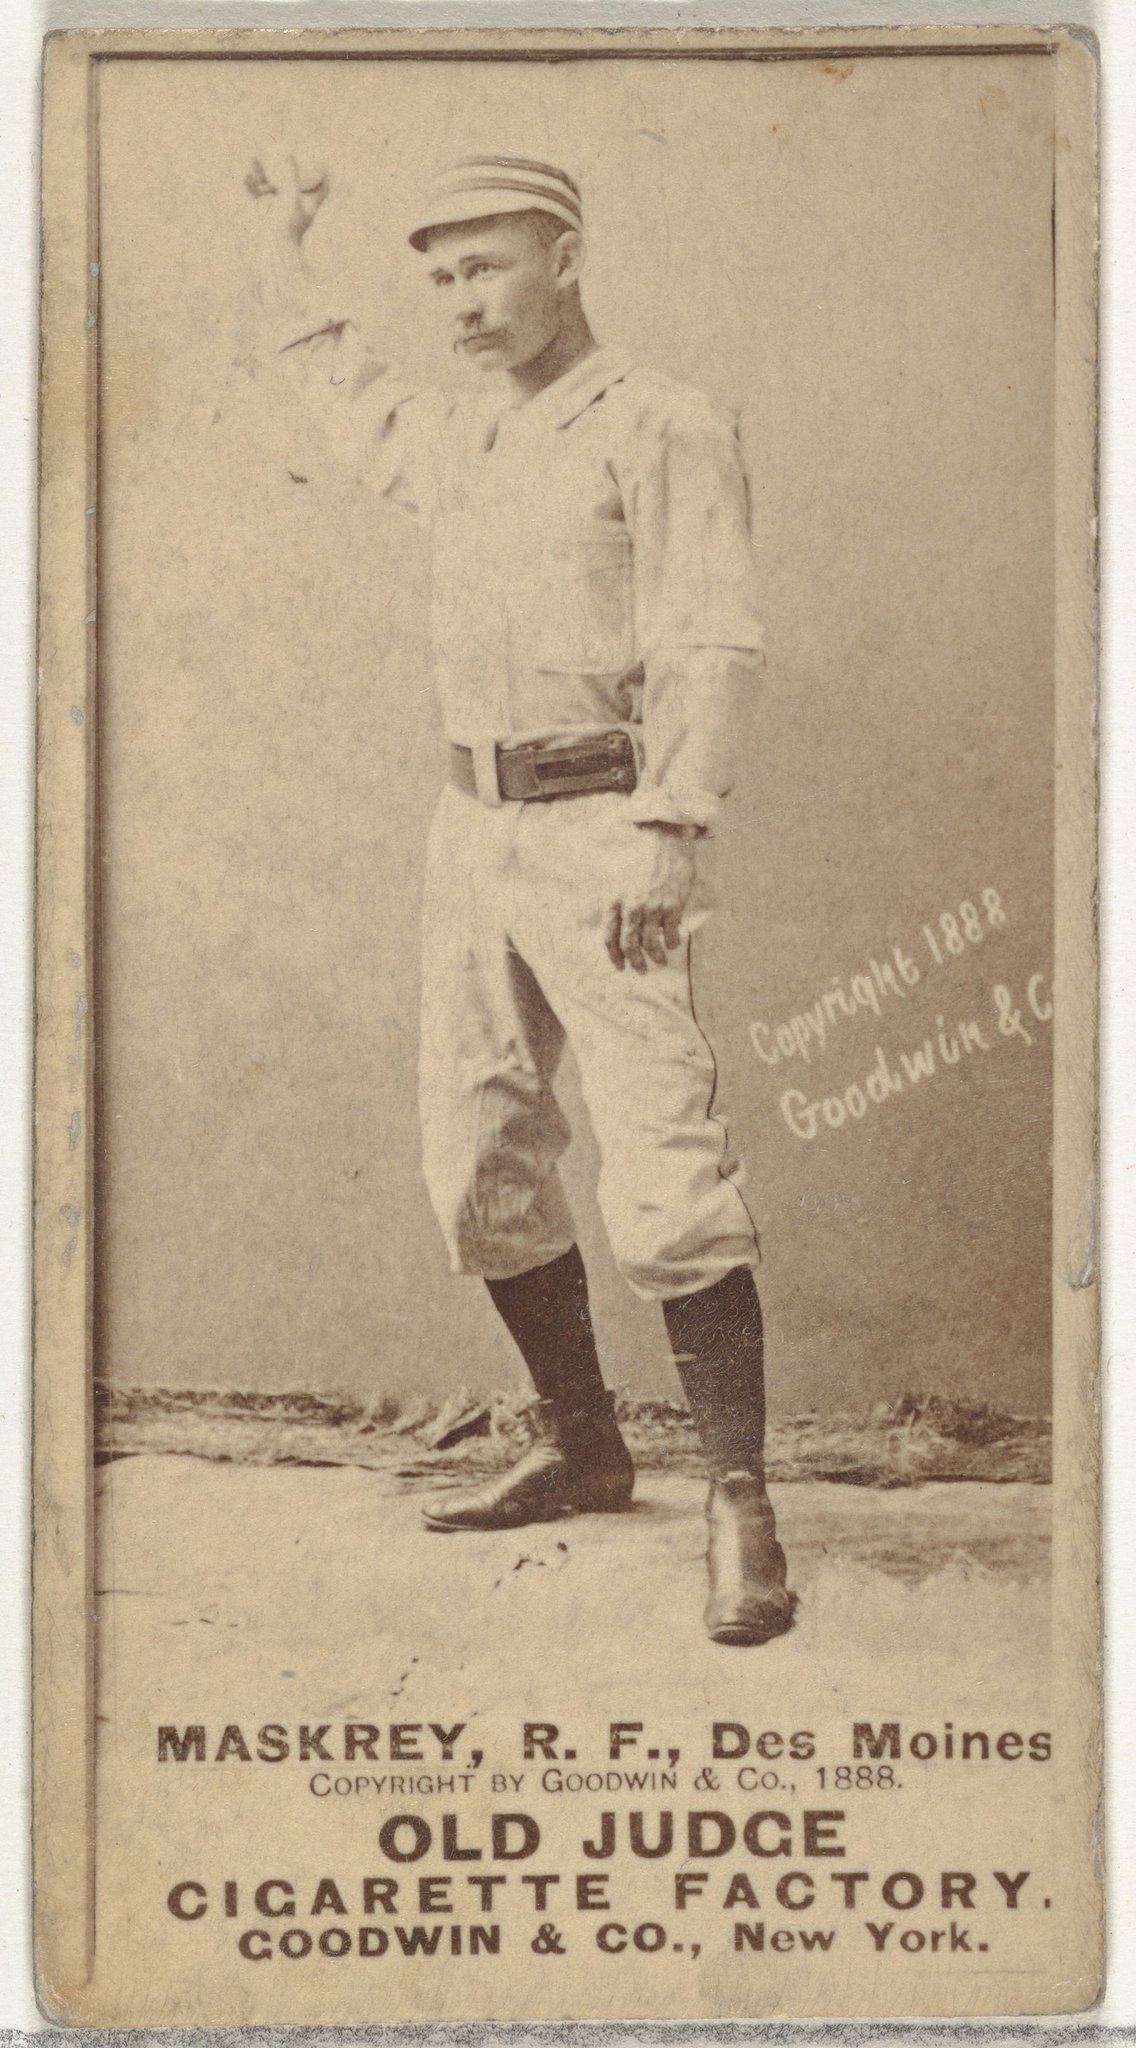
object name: baseball card, photograph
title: Samuel Leech Maskrey, Right Field, Des Moines Prohibitionists, from the Old Judge series (N172) for Old Judge Cigarettes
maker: goodwin & company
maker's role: publisher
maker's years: 1850-1950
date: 1888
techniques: albumen silver print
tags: men,portraits,baseball,athletes